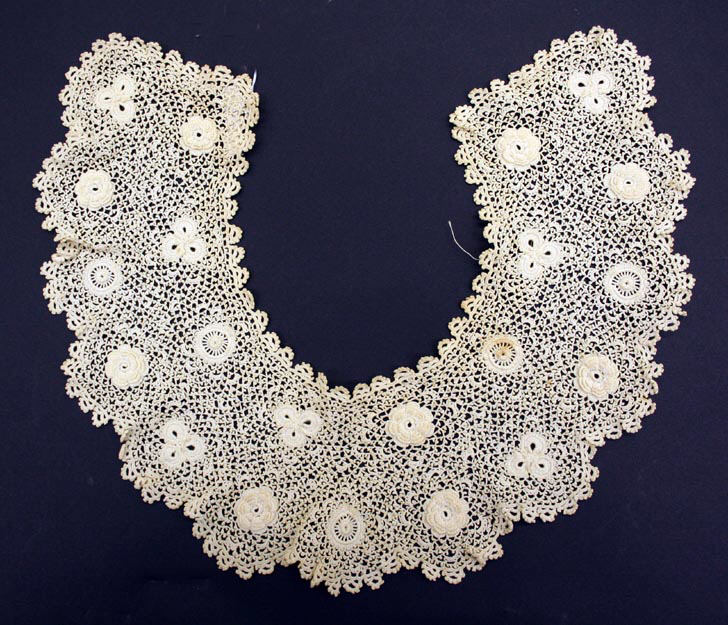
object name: collar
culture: american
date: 1700-1943